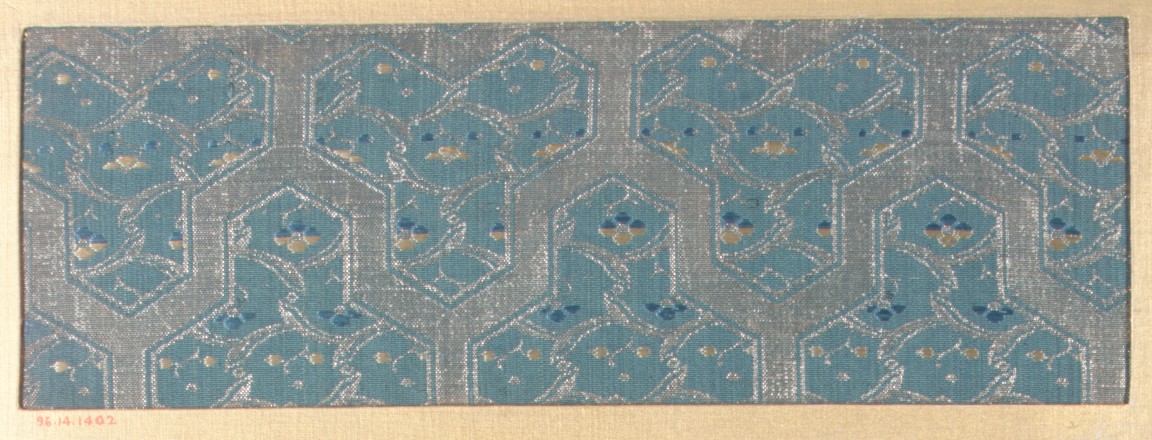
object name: piece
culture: japanese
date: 1701-1900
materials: silk